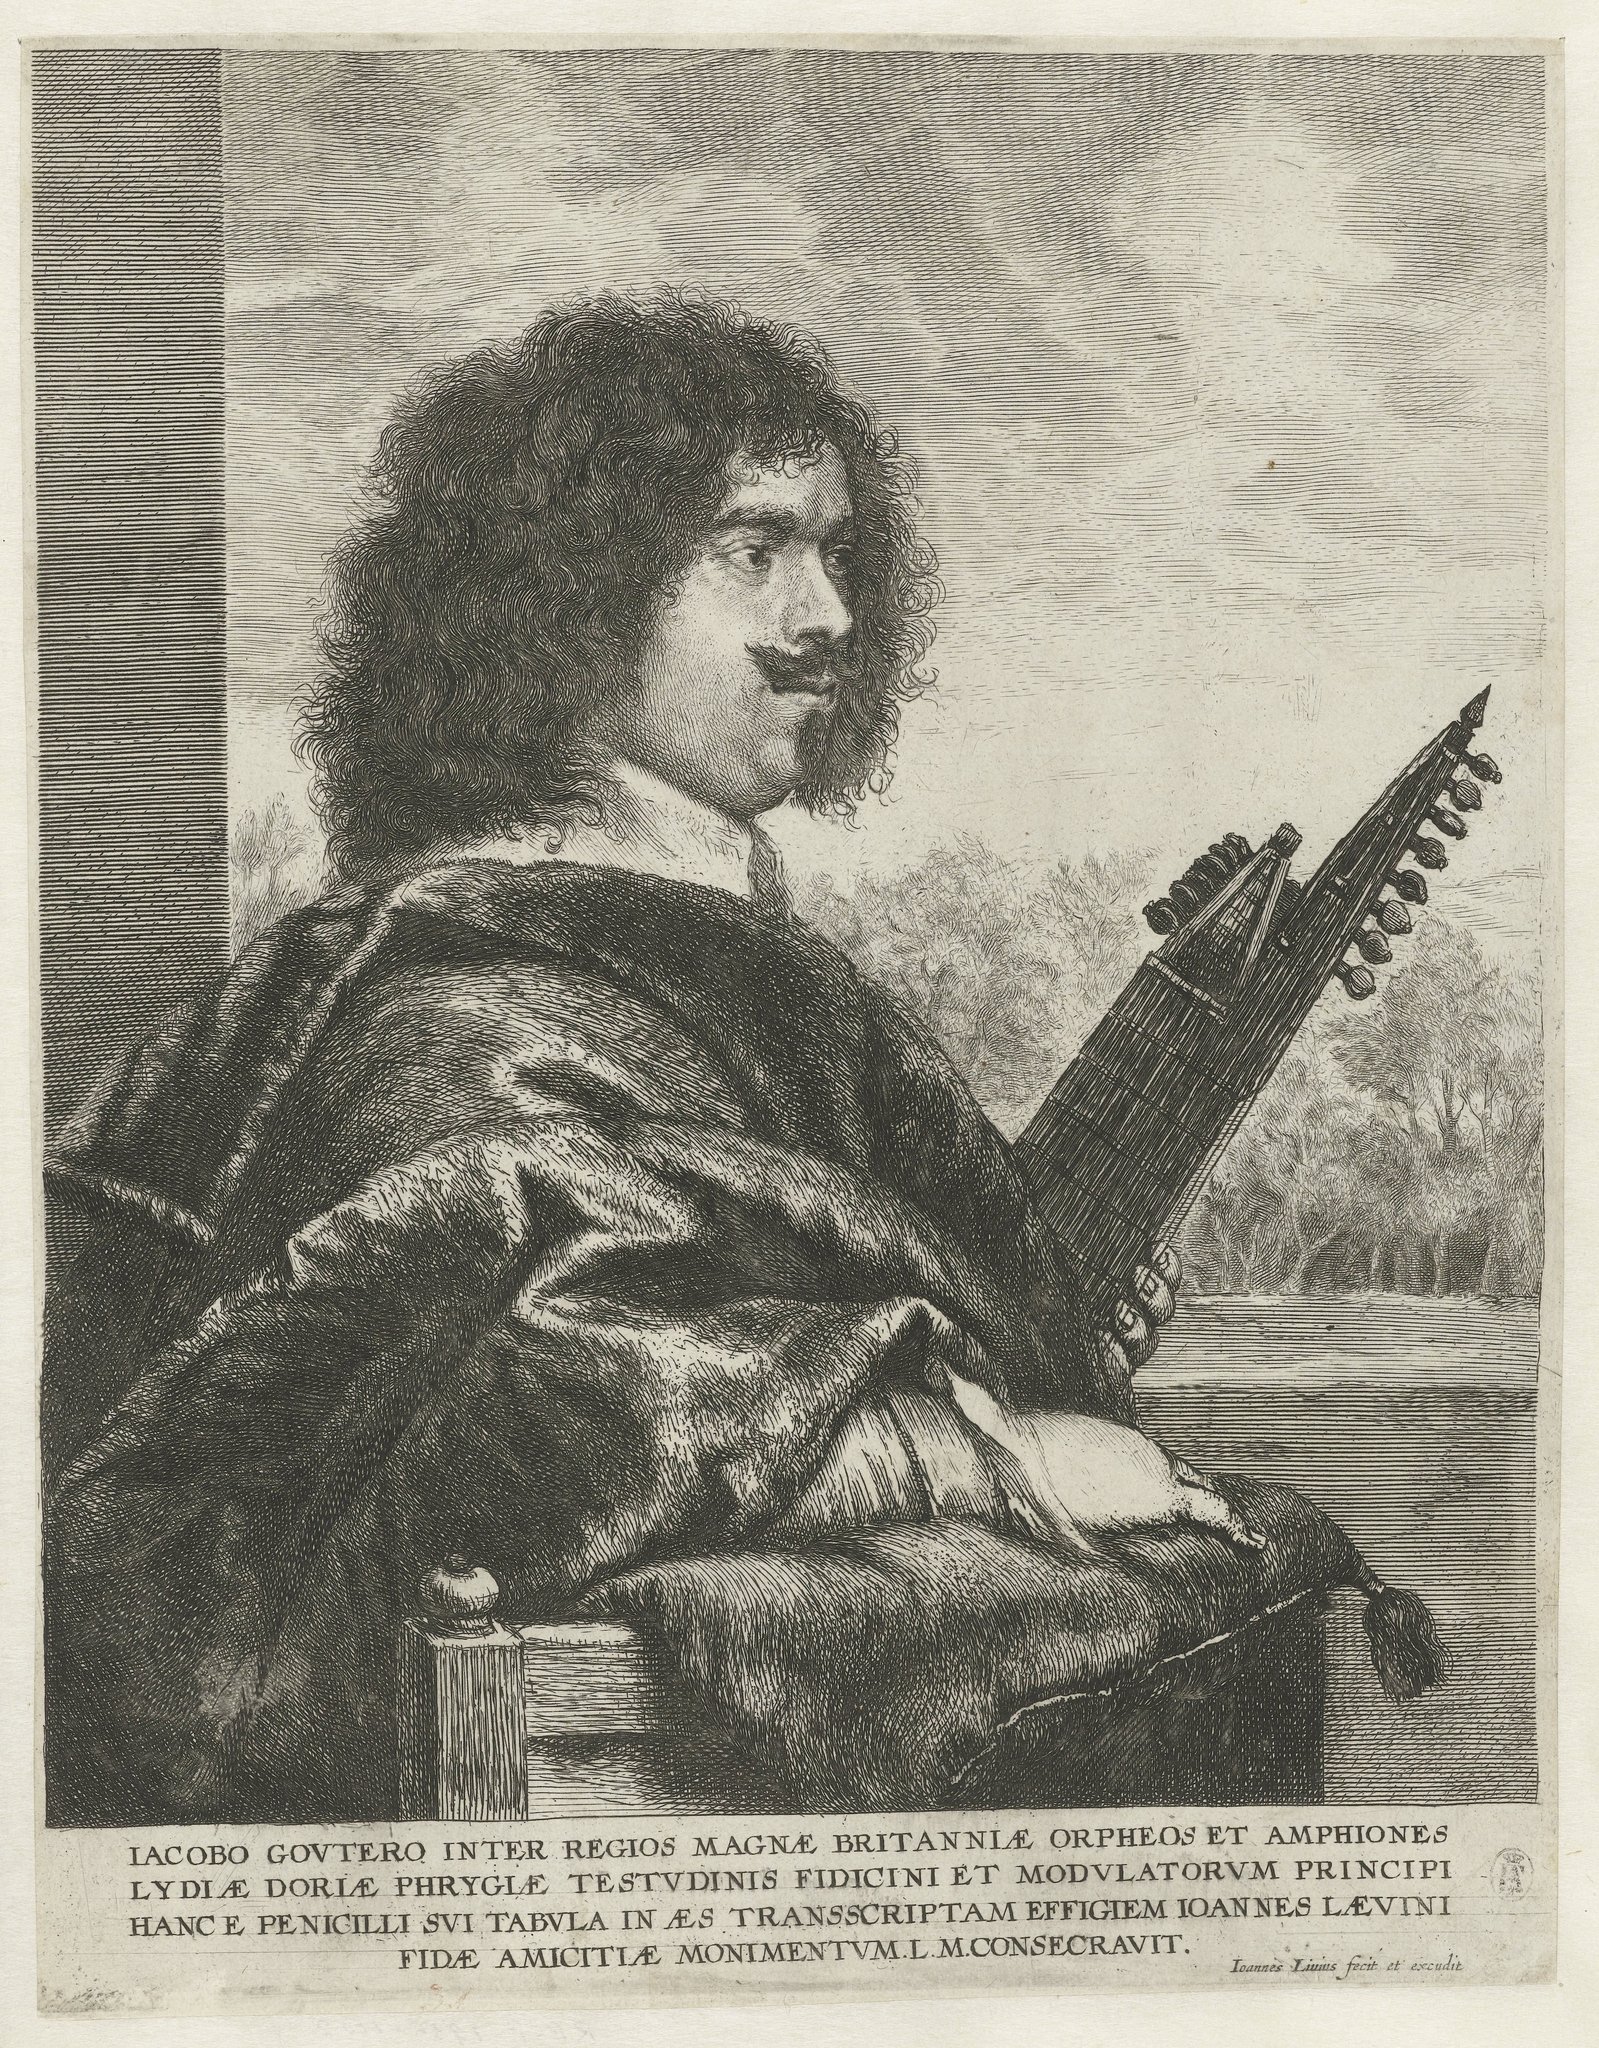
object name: print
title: Portret van de Franse luitspeler en componist Jacques Gaultier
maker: jan lievens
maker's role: draughtsman, painter, print maker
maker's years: 1607-1674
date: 1632-1635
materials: paper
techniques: engraving, etching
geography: great britain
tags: portrait of a musician, portrait of composer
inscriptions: collector's mark: Lugt 2228, collector's mark: Lugt 2166, collector's mark: Lugt 971, collector's mark: Lugt 2228a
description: Portret van de Franse luitspeler en componist Jacques Gaultier met zijn instrument de luit. Volgens het Latijnse onderschrift werd het portret uit vriendschap vervaardigd.